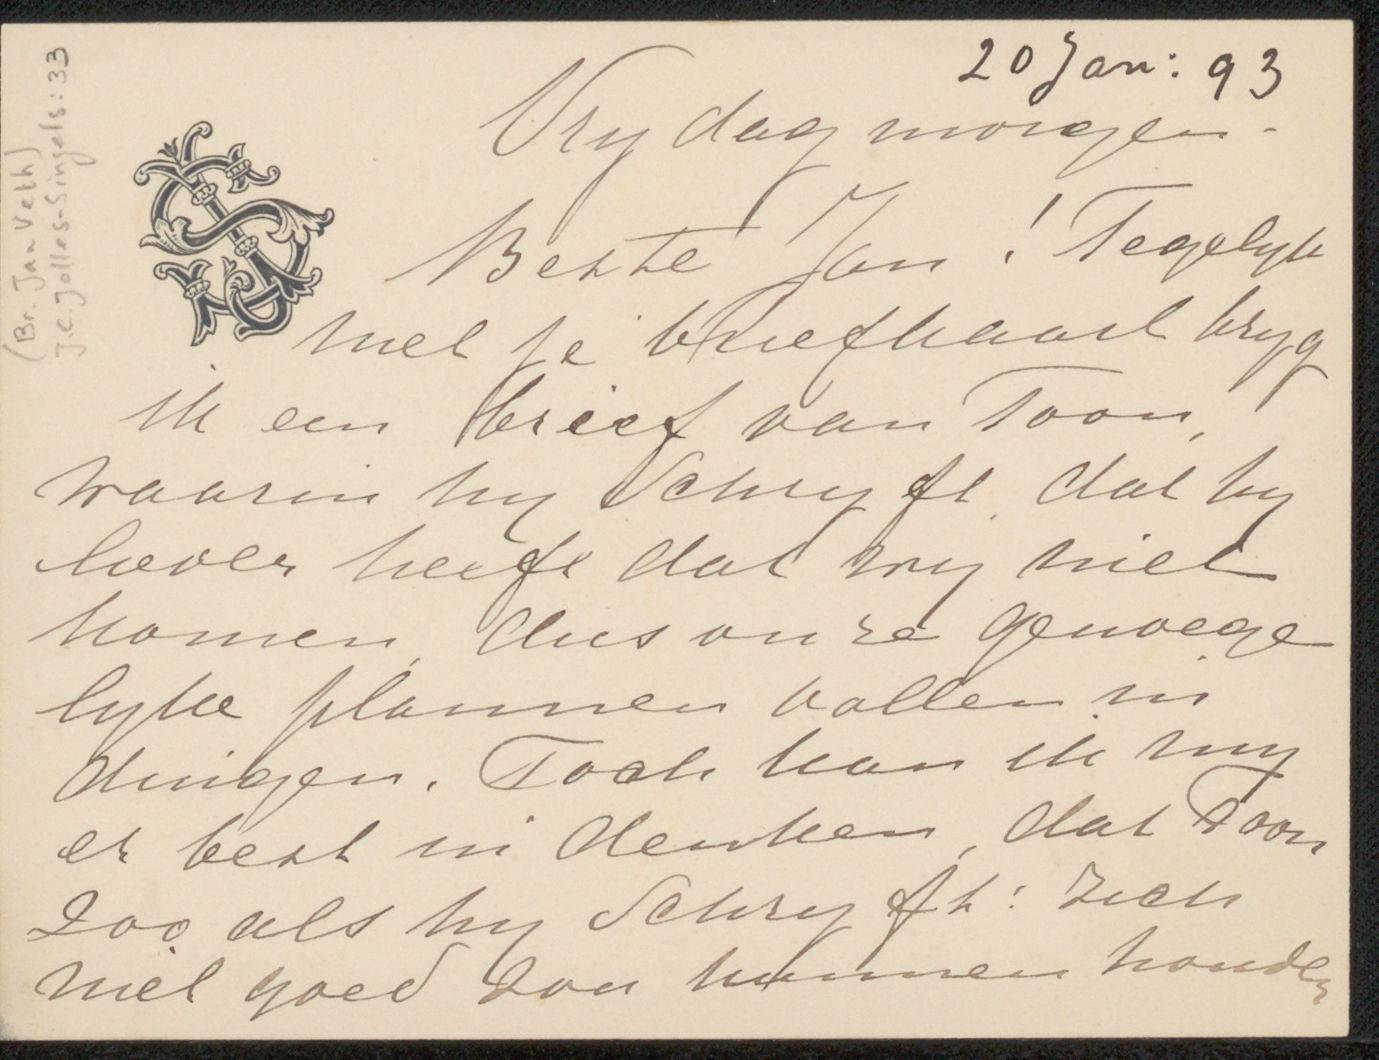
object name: letter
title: Brief aan Jan Veth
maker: jacoba cornelia jolles-singels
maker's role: schrijver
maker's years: 1847-1901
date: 1893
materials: cardboard, ink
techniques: pen, writing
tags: painter, print maker, draughtsman, designer, jan veth, antoon derkinderen, painting (including book-illumination, miniature-painting), den bosch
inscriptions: monogram: ‘JS’, collector's mark: ‘RPK’